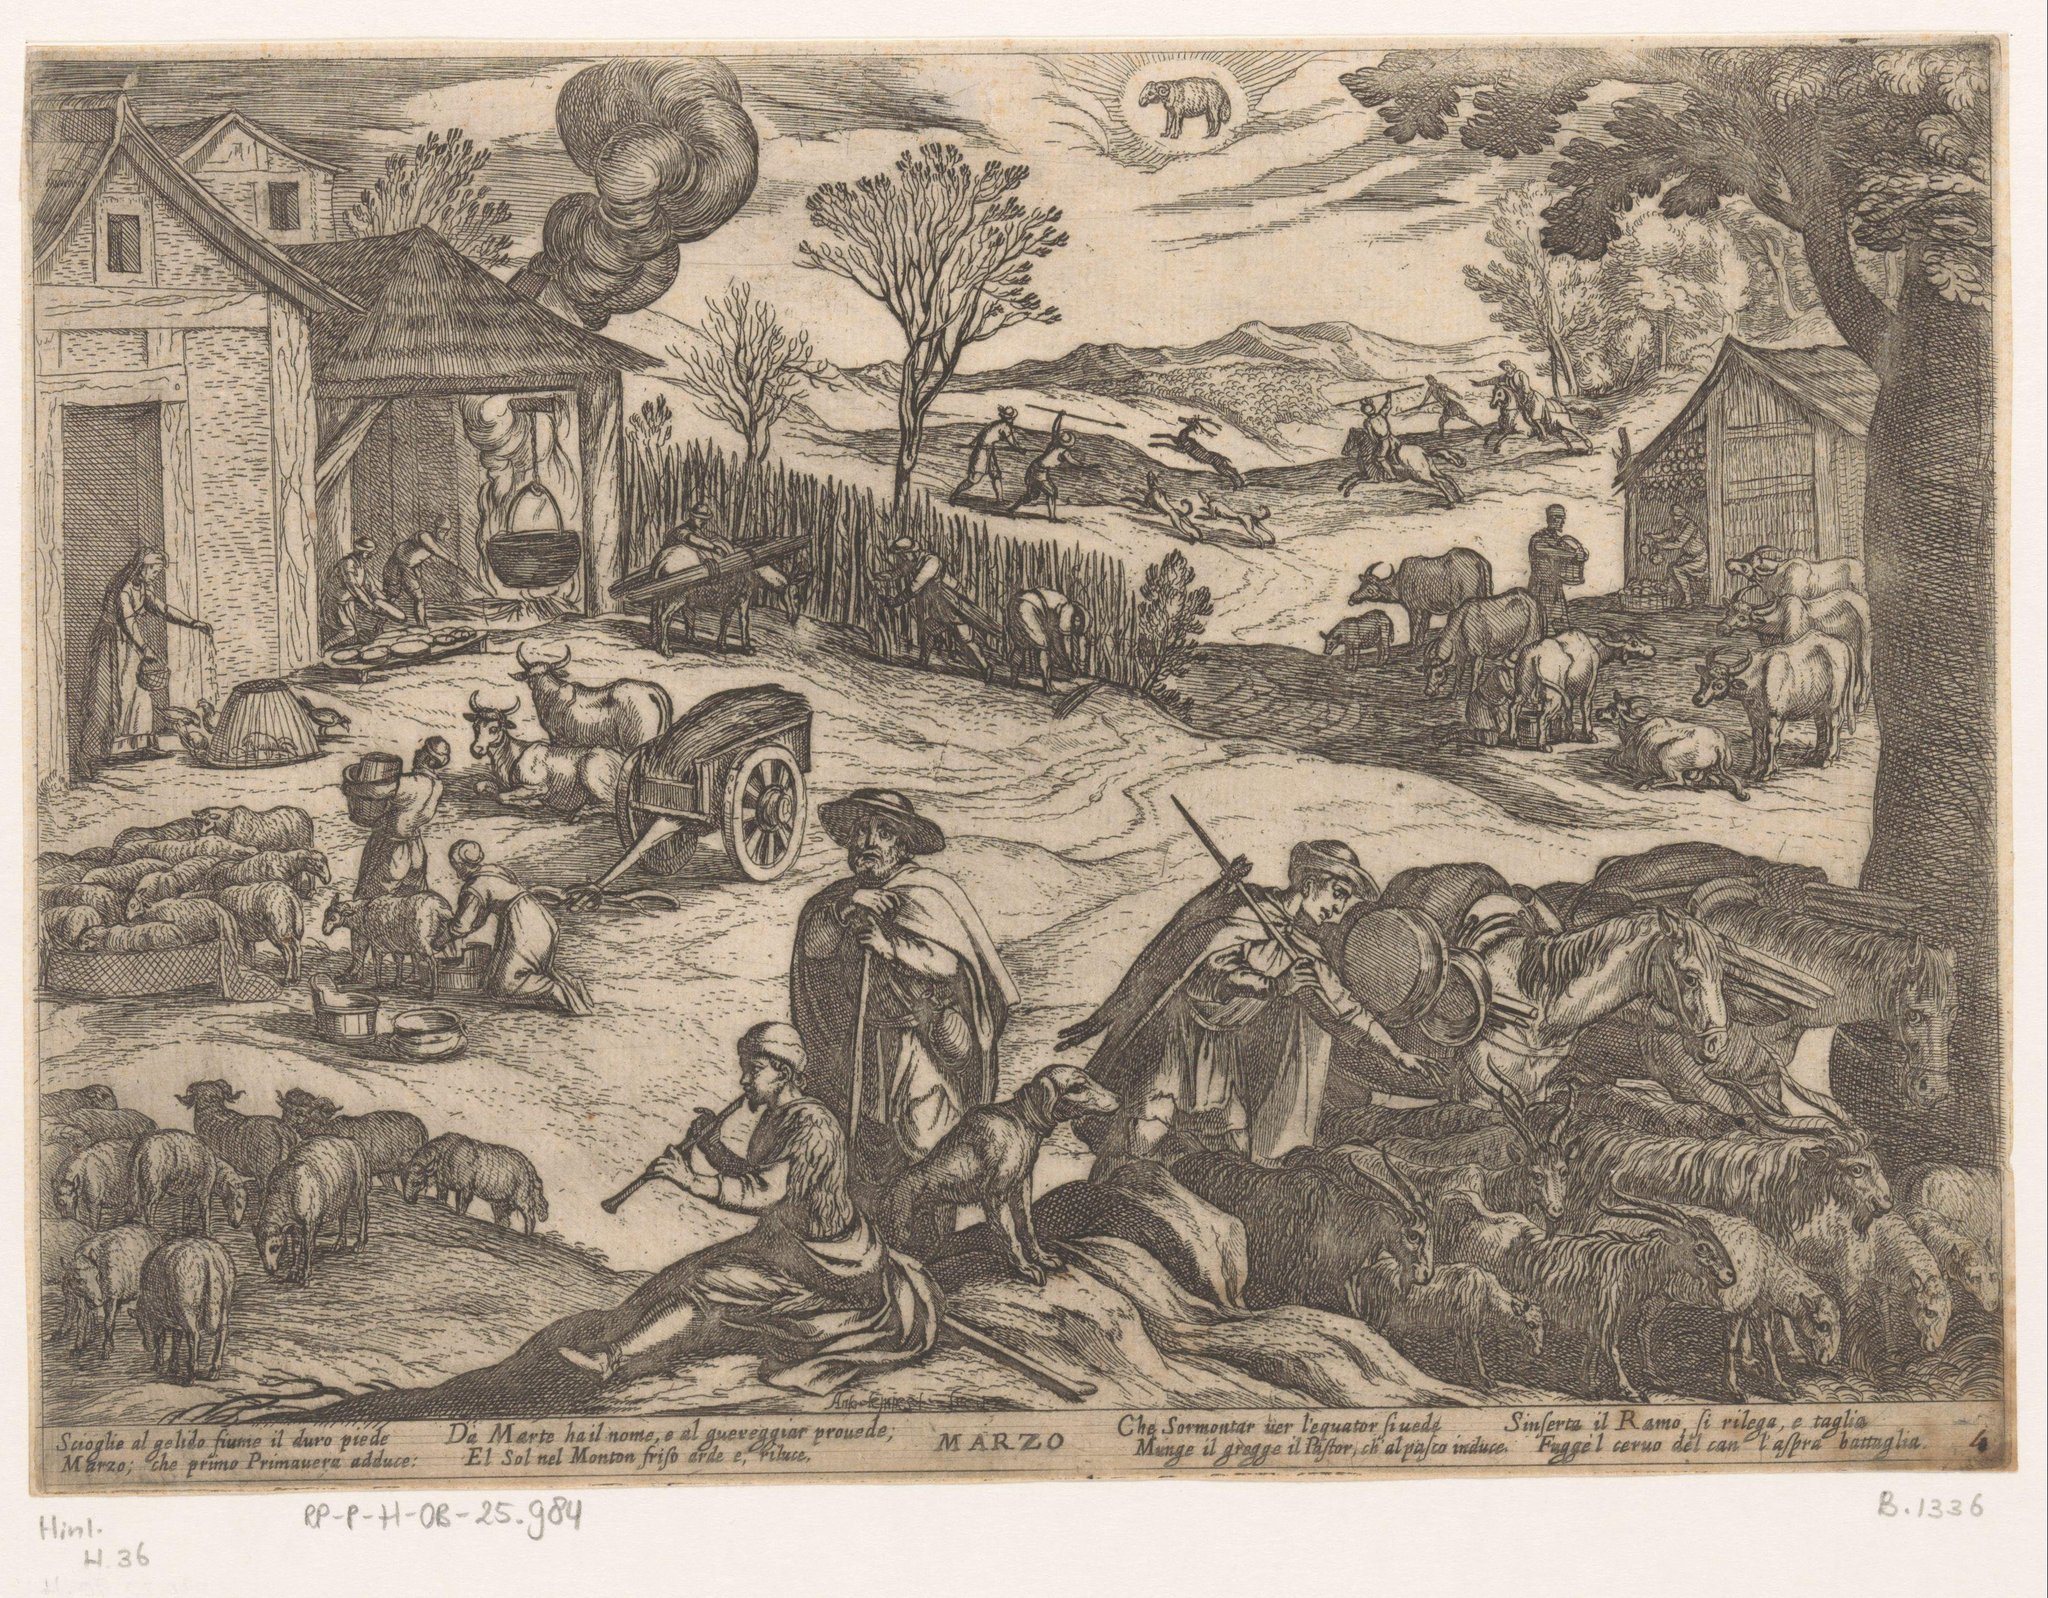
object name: print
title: Maart: boeren activiteiten (ram)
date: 1599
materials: paper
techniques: etching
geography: italy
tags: the twelve months represented by scenes showing human activities, usually in a landscape; so-called 'labours of the months', herding, herdsman, herdswoman, shepherd, shepherdess, cowherd, etc., cattle, hunters hunting (n.b.: in 1988-1990 this notation denoted the concept of 43c11421 'hunters resting during the hunt'), farmers, aries (zodical sign of march), herd, flock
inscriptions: collector's mark: ‘Hinloopen’, number: ‘4’, collector's mark: Lugt 11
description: Verbeelding van menselijke activiteit in de maand maart. Landschap met herders met hun kudde, boeren met hun vee en jagers jagend op een hert. Midden boven het symbool voor het sterrenbeeld ram. Italiaans vers en titel in ondermarge.